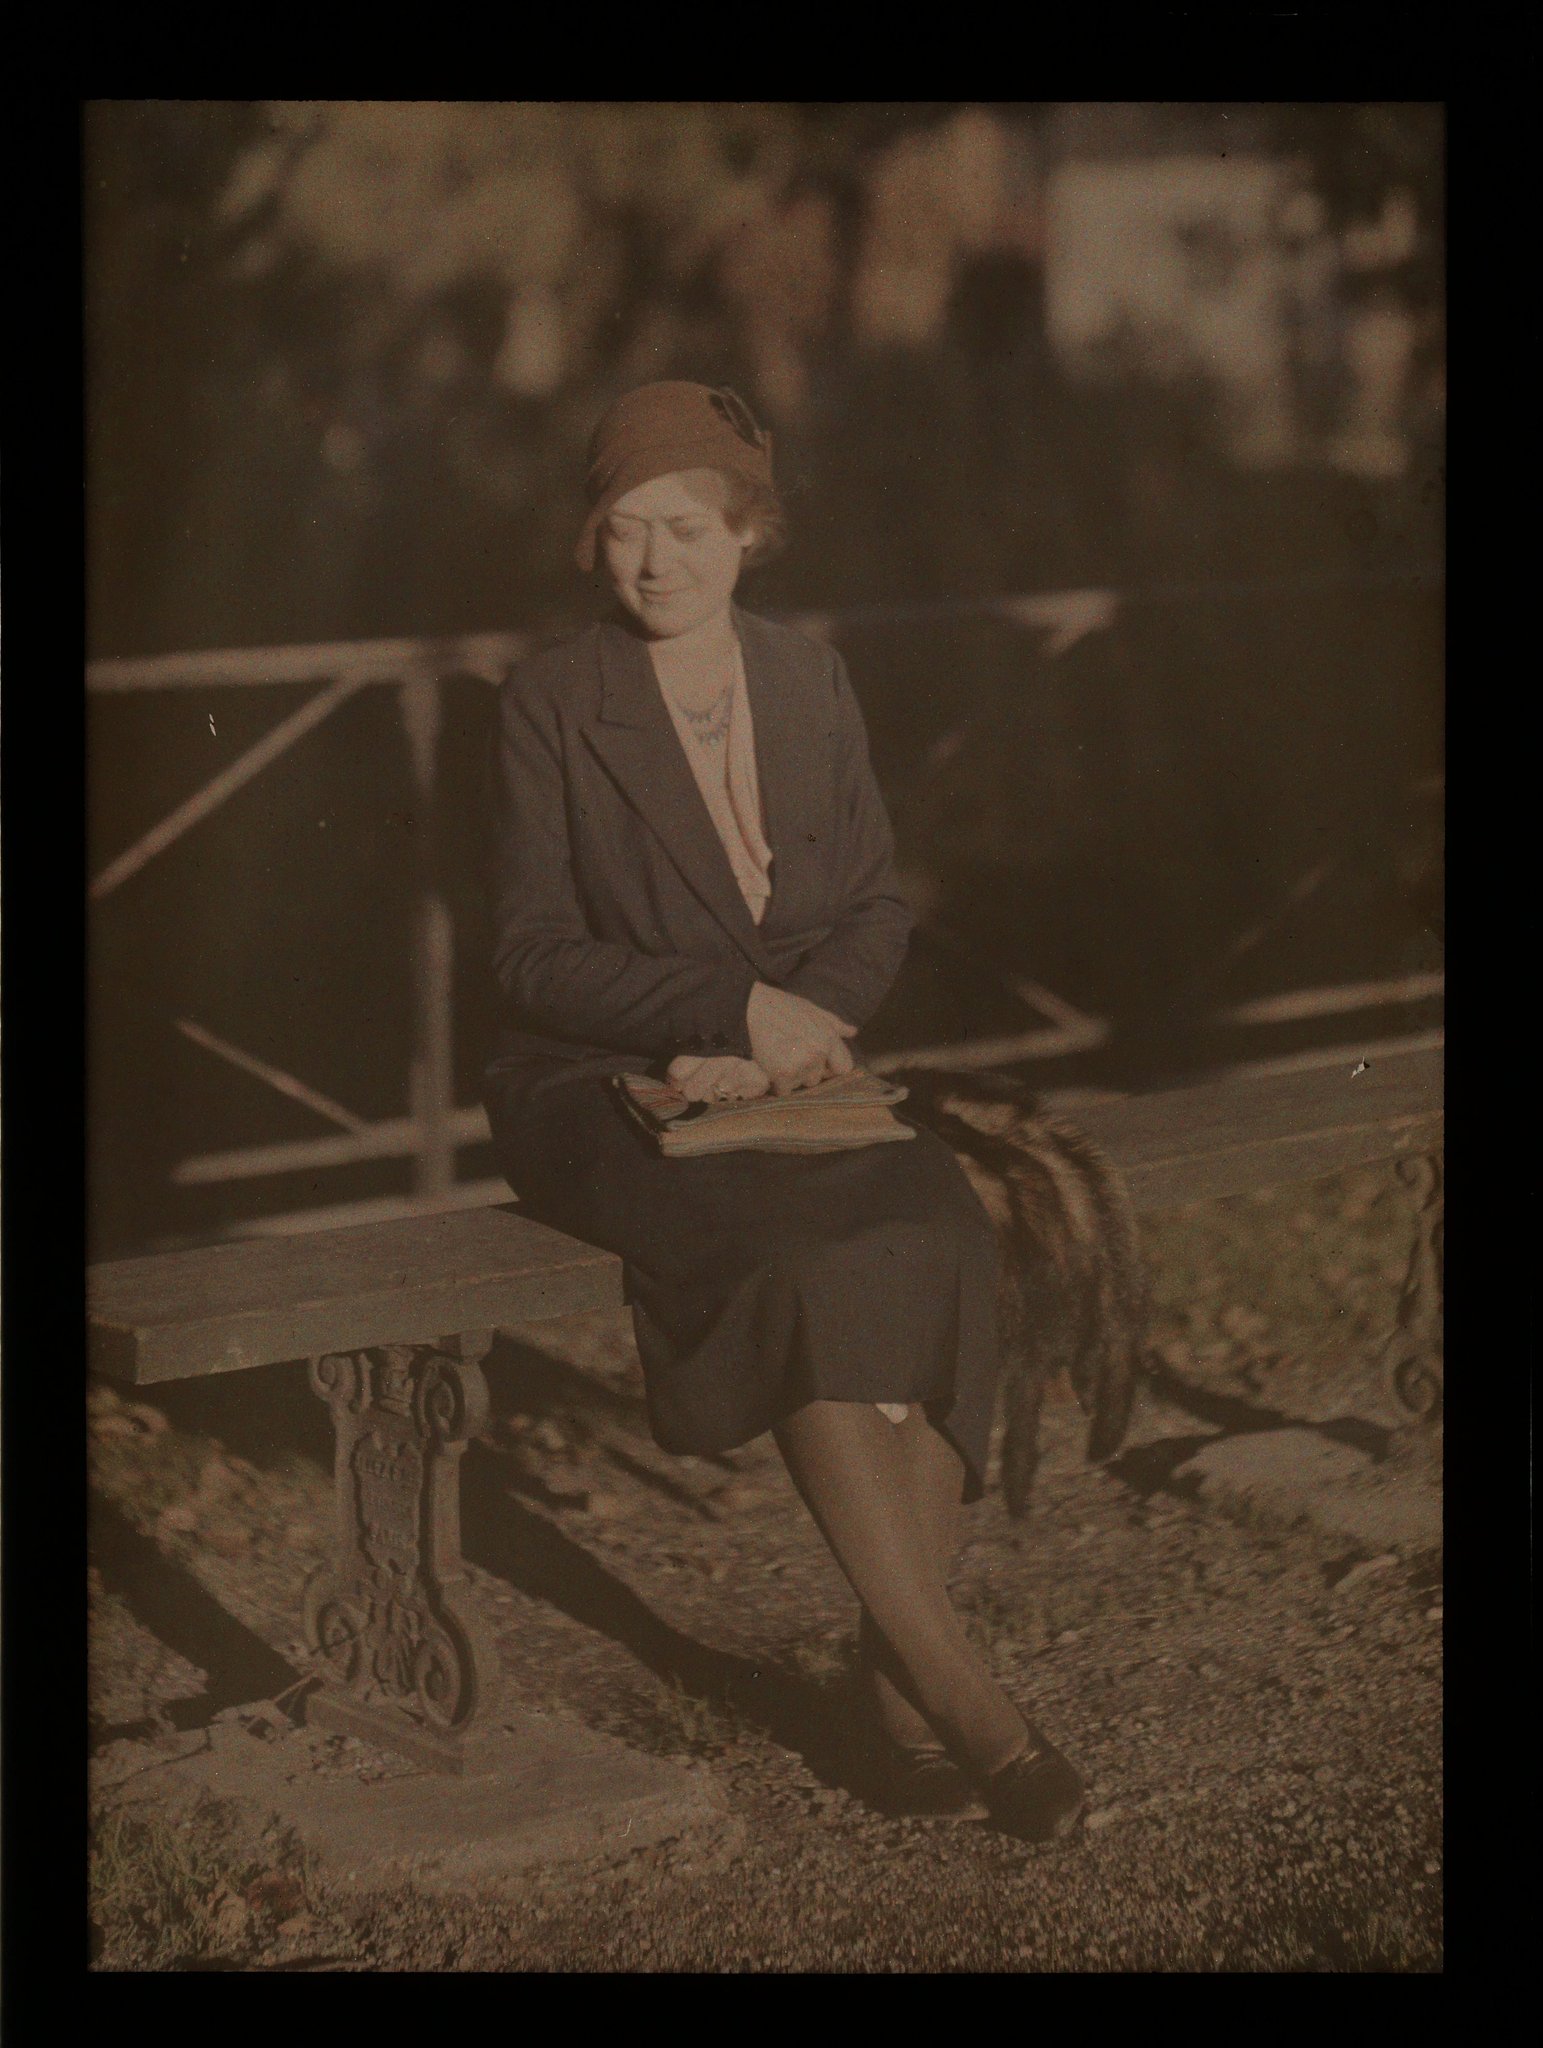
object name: photograph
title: Vrouw gezeten op een bankje op een brug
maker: Anonymous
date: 1910-1940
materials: glass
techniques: autochrome process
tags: bench